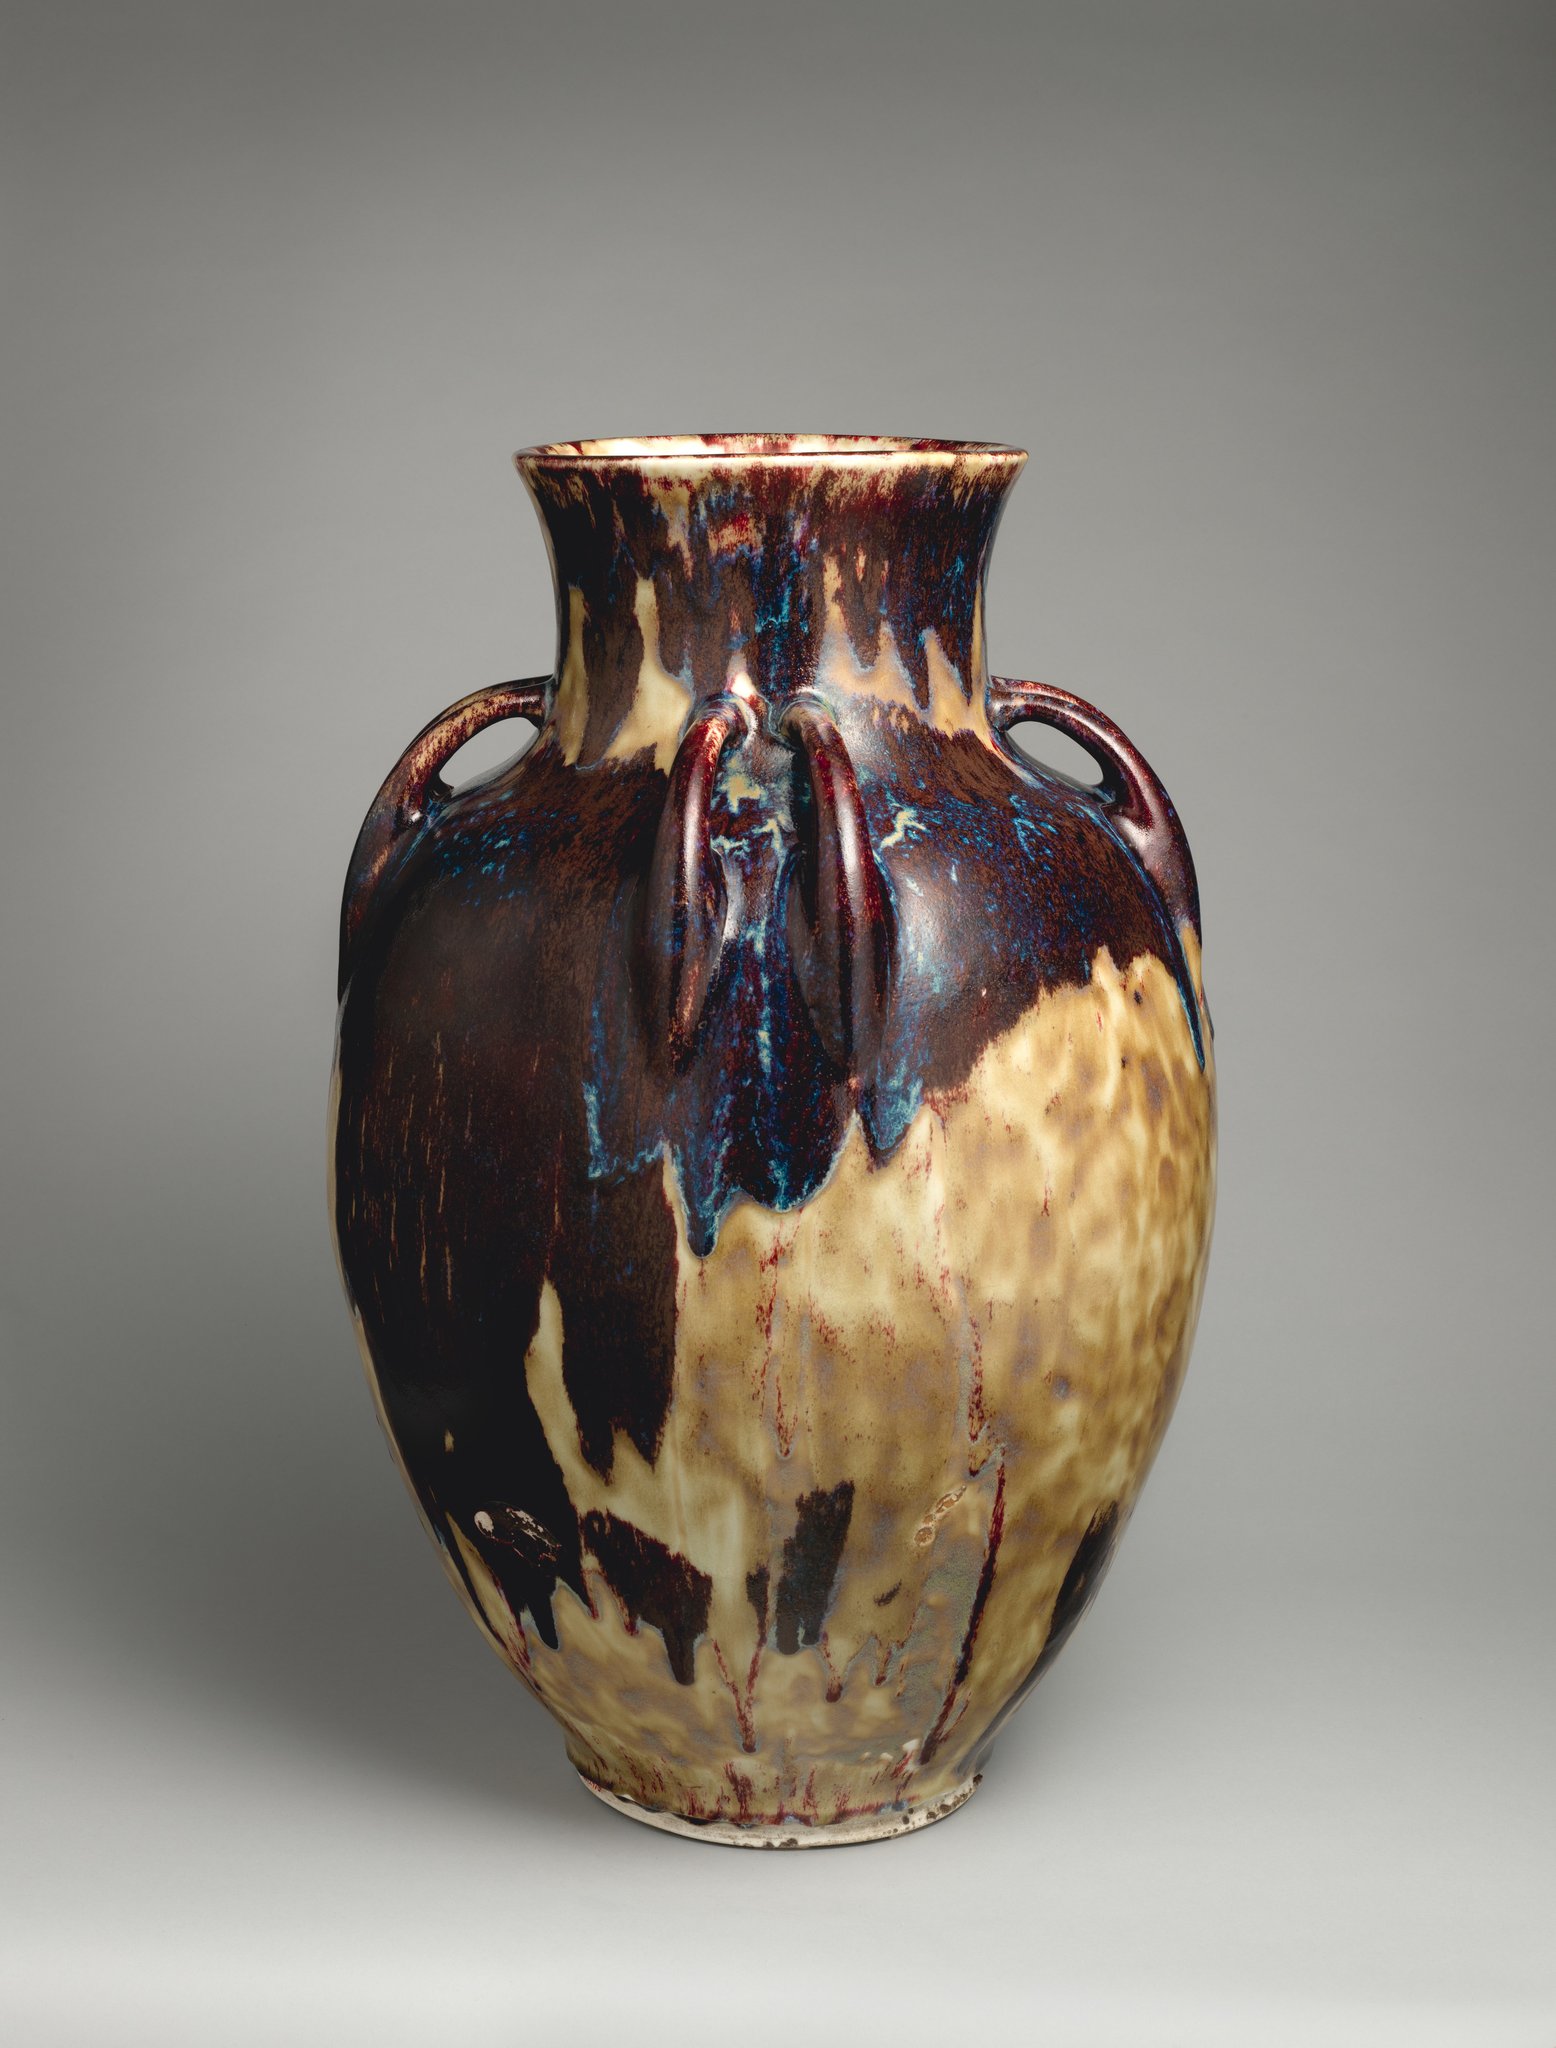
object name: vase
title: Monumental vase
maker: ernest chaplet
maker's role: maker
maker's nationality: french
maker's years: 1835-1909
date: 1890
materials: porcelain